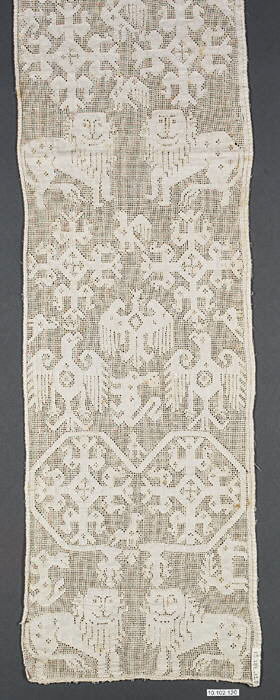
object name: drawnwork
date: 1701-1800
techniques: embroidery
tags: birds,lions